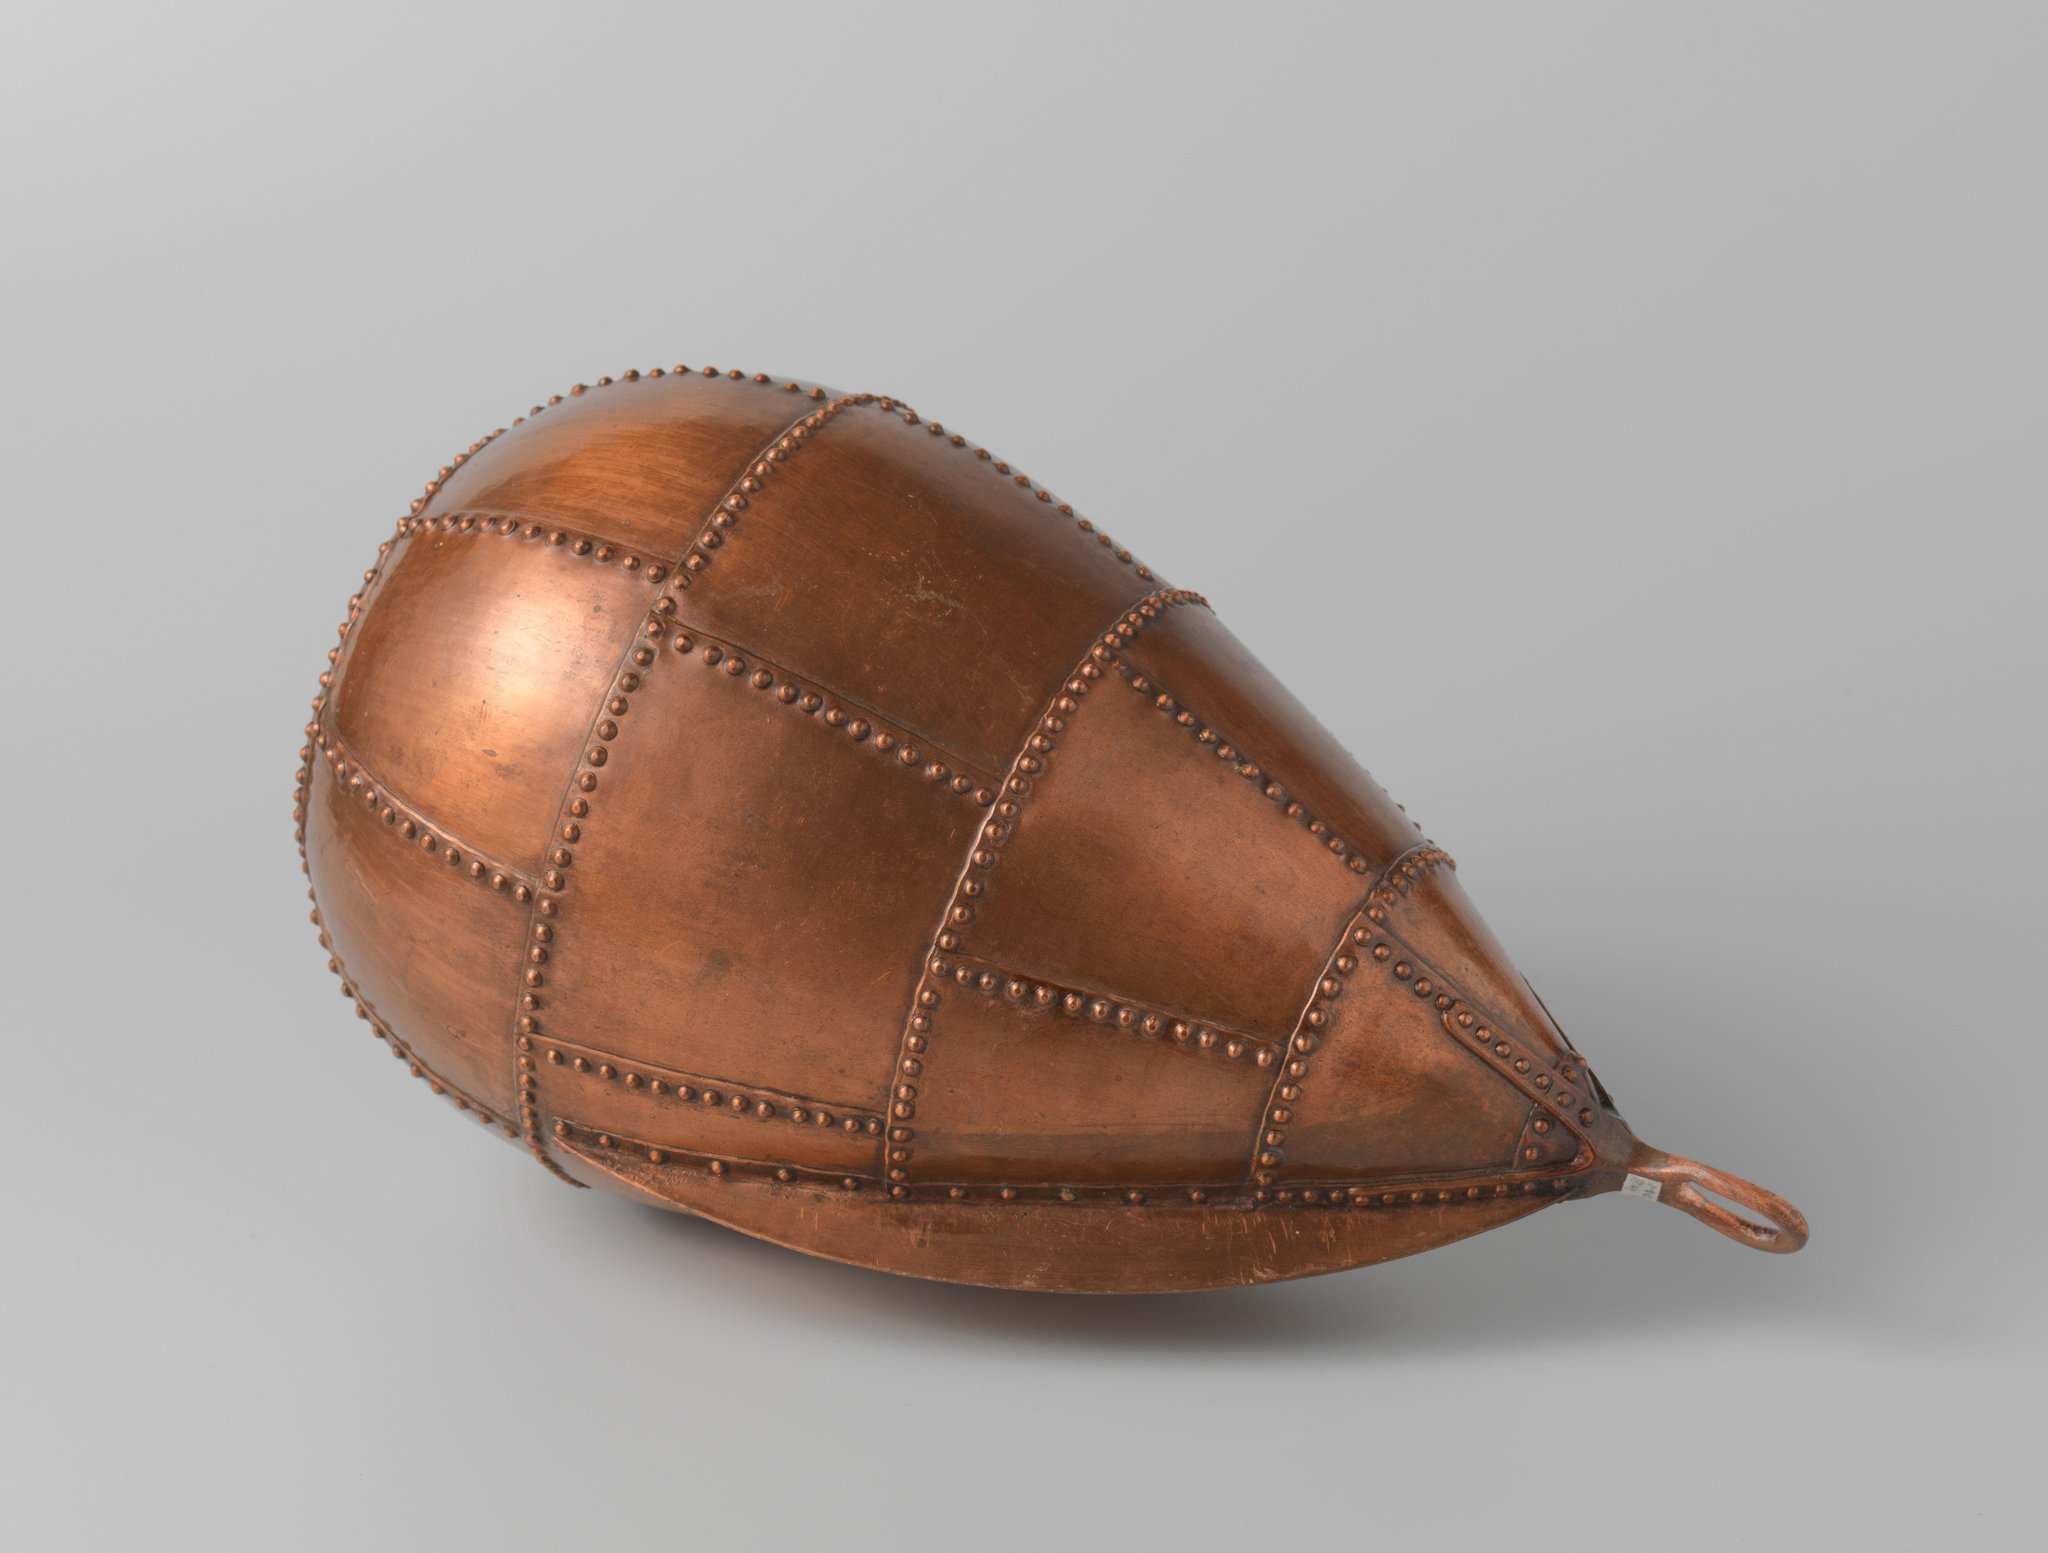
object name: test model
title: Model of a Buoy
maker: petrus van der loo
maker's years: 1806-1864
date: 1842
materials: copper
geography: the hague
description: Koperen model van een ijzeren boei of zeeton, gemaakt van aaneengeklonken platen. Het heeft een conisch lichaam met scherp uiteinde onder en een bolvormige bovenkant. Aan een zijde is een verticale kiel aangebracht. Het oog aan het ondereinde is afgebroken. Schaal 1:10 (archieven).